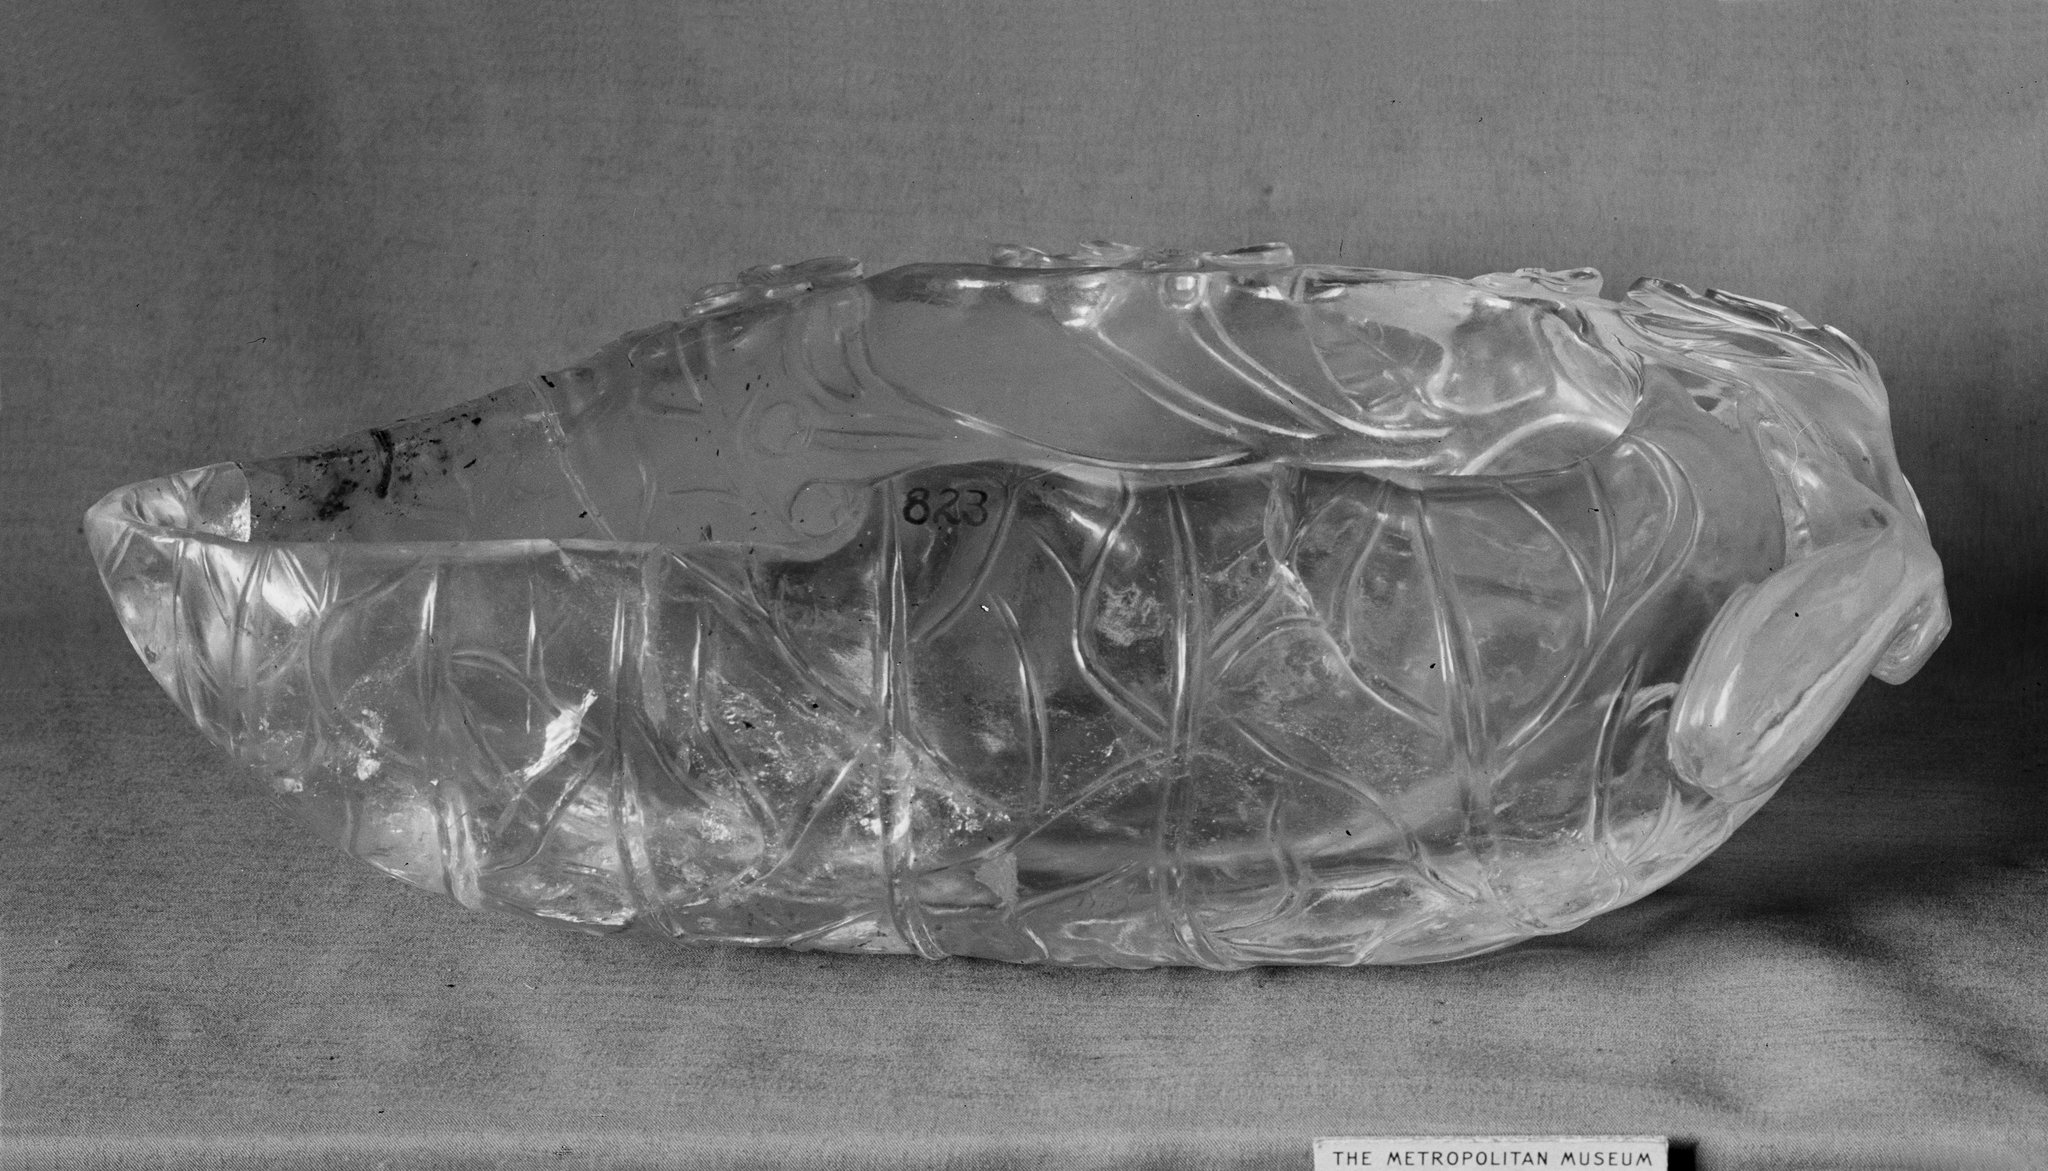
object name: dish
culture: chinese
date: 1701-1800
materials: quartz